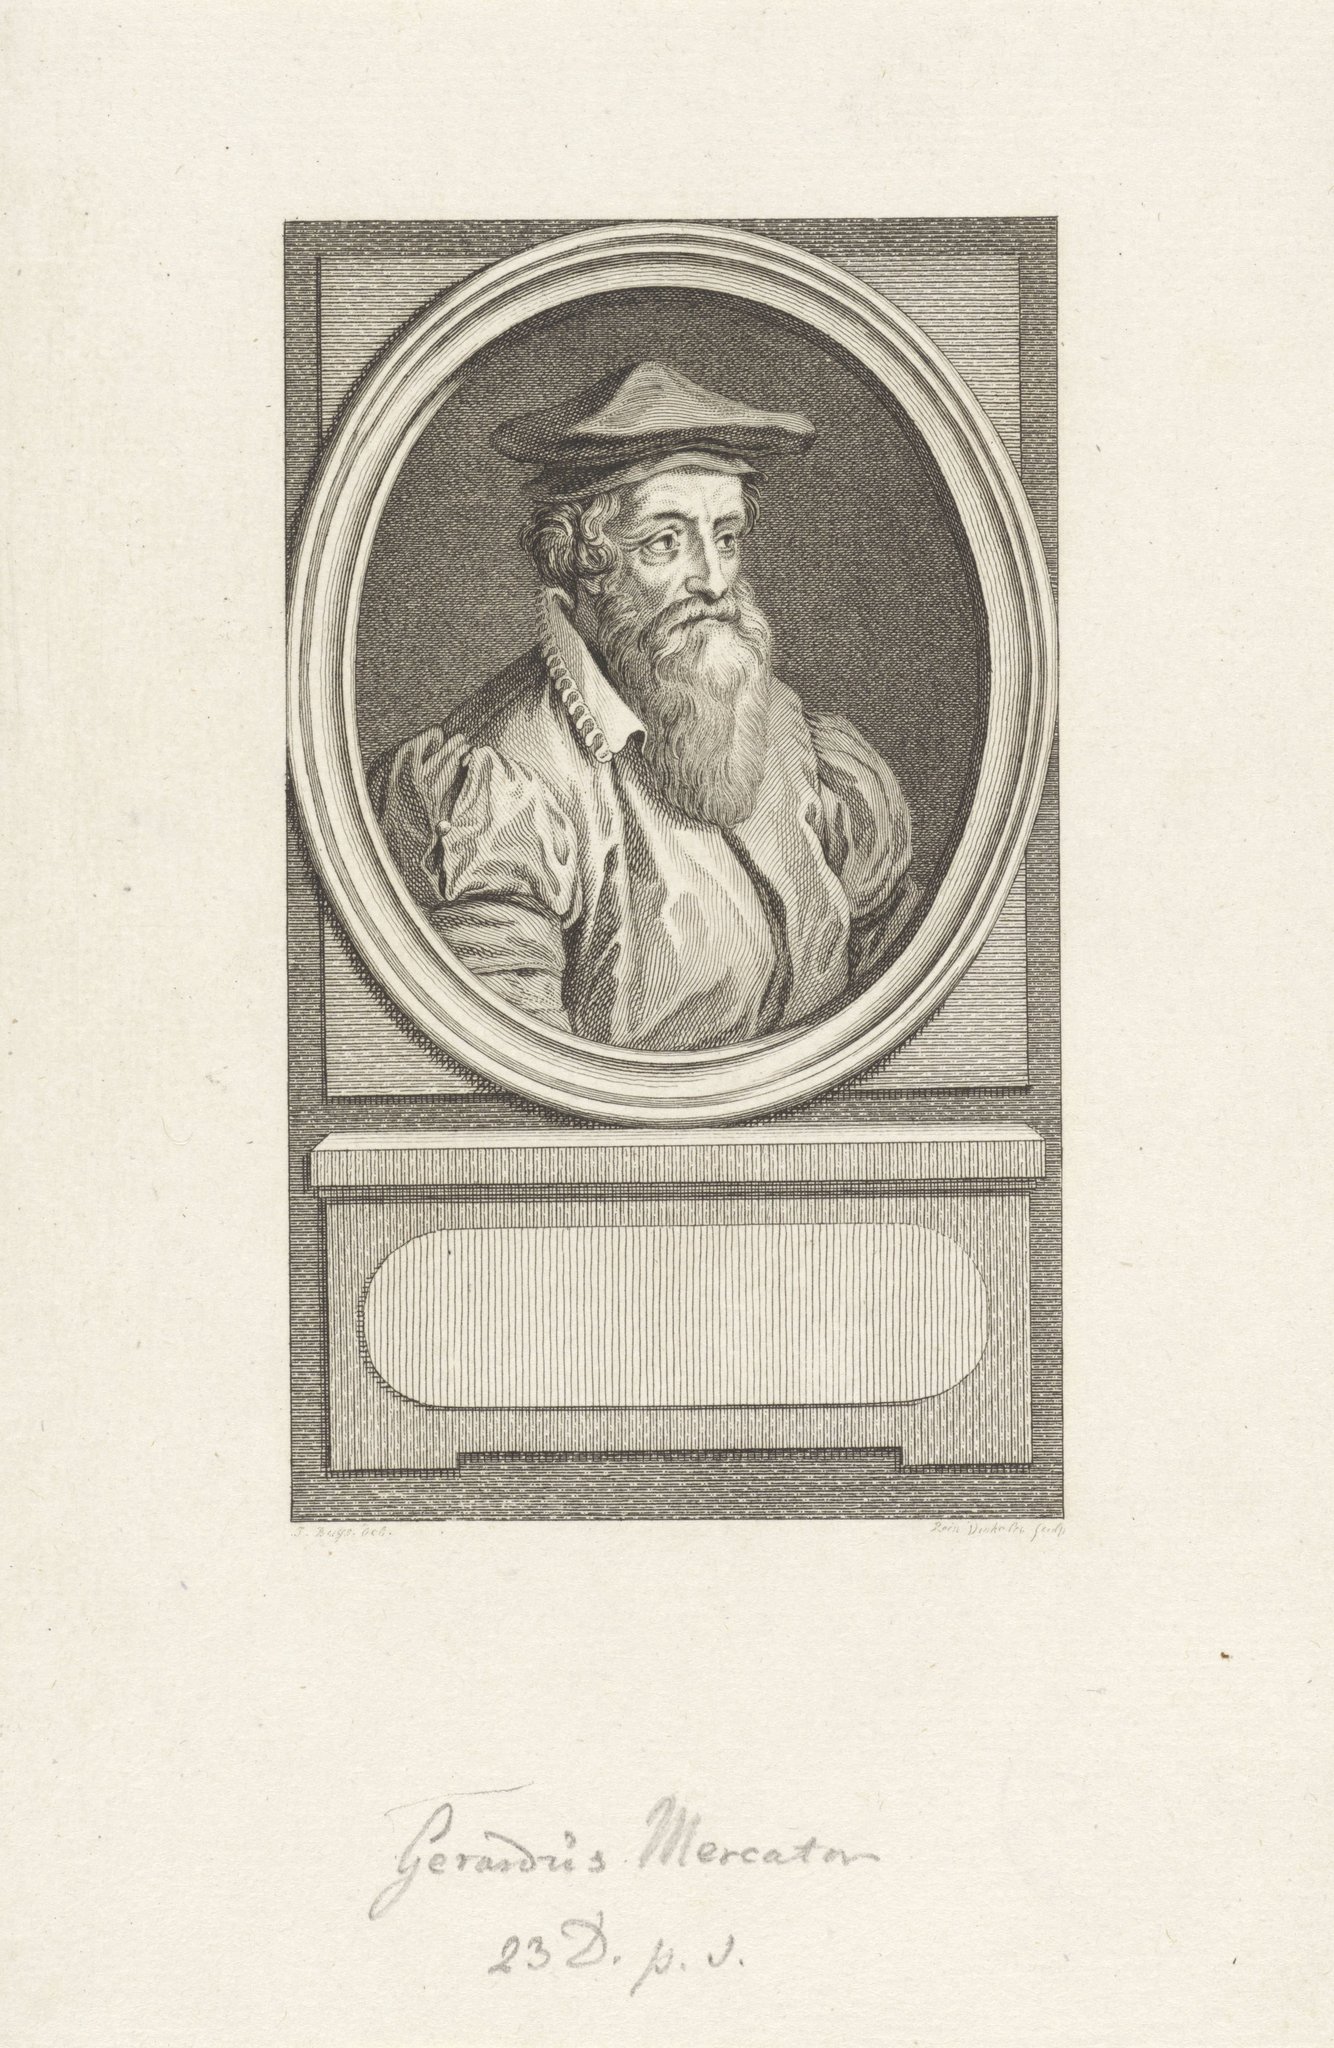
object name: print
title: Portret van de cartograaf Gerardus Mercator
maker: reinier vinkeles (i)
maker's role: draughtsman, print maker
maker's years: 1741-1816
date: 1790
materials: paper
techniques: engraving, etching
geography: amsterdam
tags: instrument maker, gerardus mercator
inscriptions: collector's mark: Lugt 240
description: Latere staat prent gebruikt als boekillustratie in: Kok, Jacobus. Vaderlandsch woordenboek : met kaarten, plaaten en pourtraitten. Amsterdam: Johannes Allart, 1785-1796. Deel XXIII.